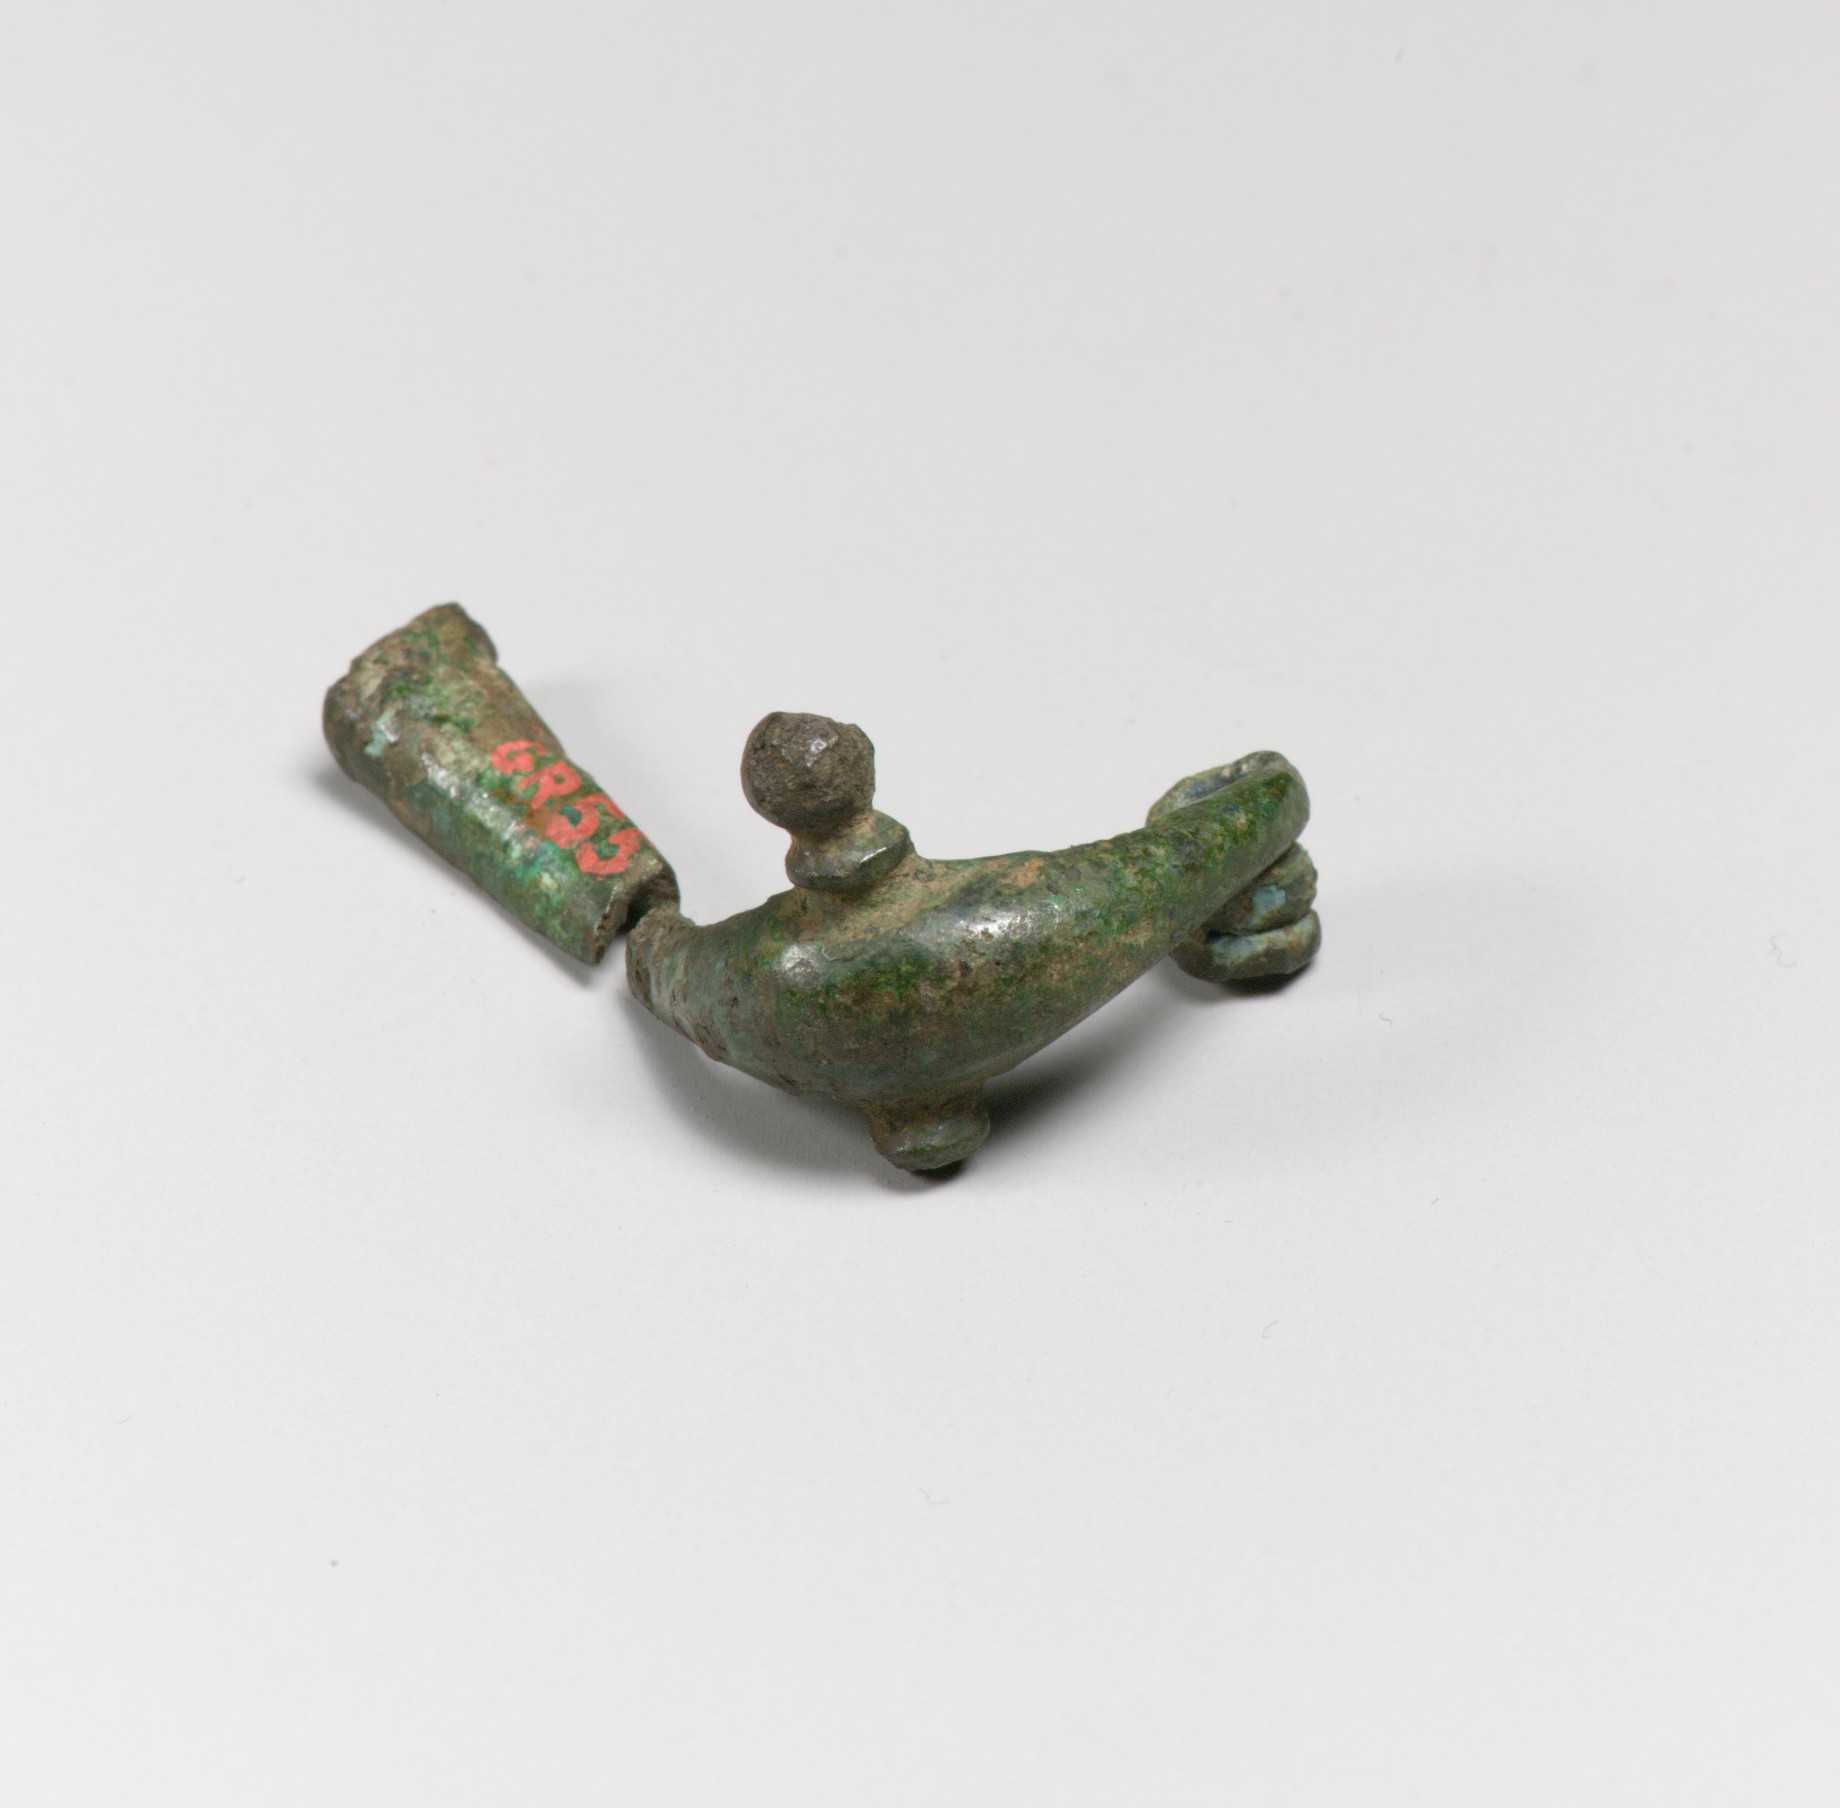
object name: fibula, boat shaped type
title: Fibula, boat-shaped type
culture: italic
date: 800-501 BCE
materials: bronze